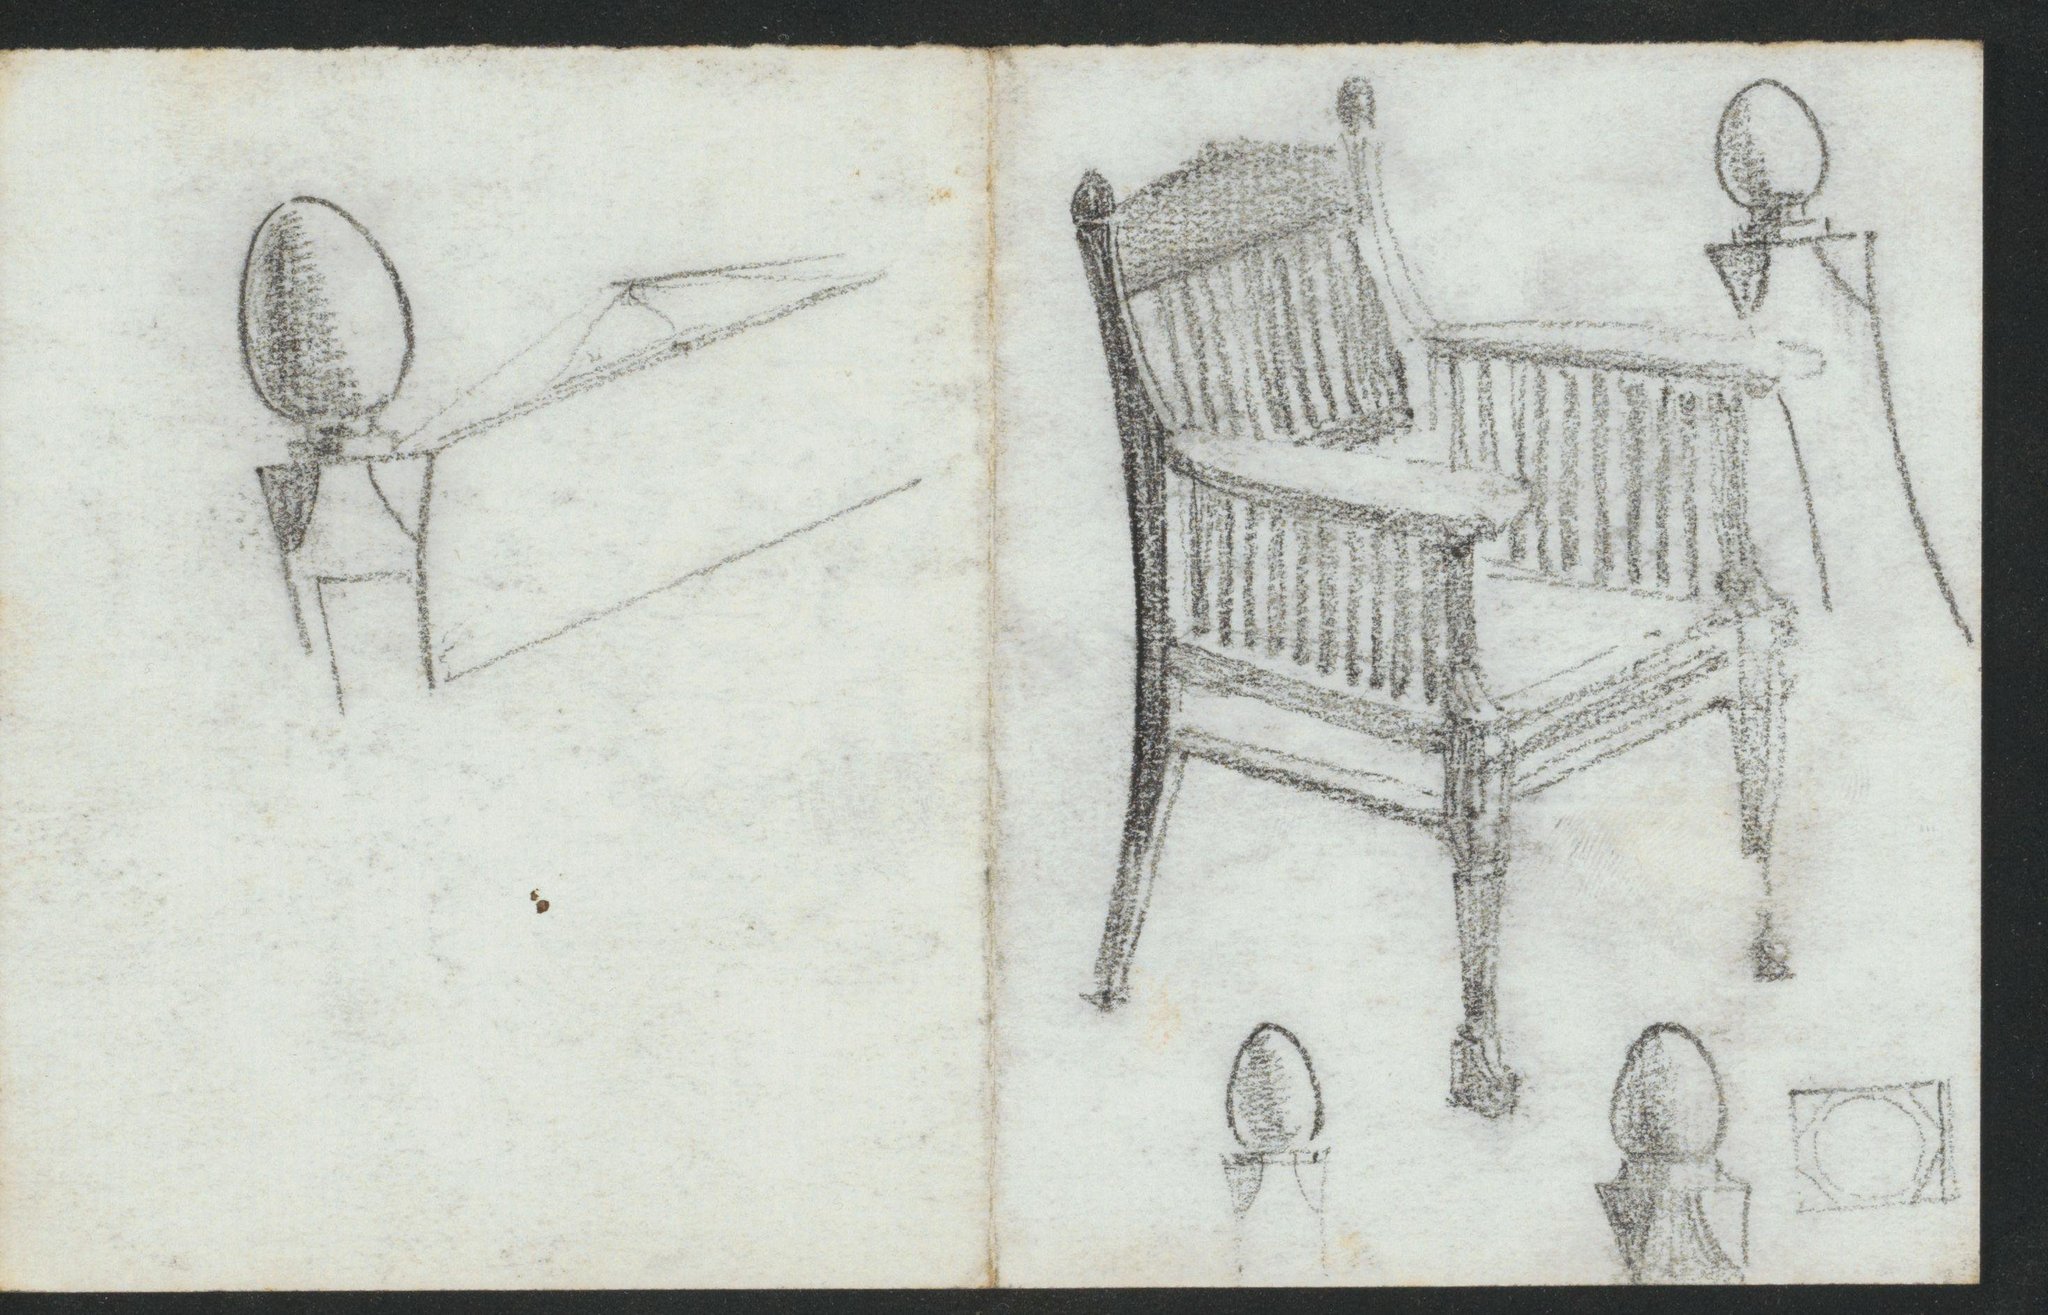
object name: drawing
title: Stoel en ornamenten op sokkels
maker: gerrit willem dijsselhof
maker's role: designer, draughtsman, print maker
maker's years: 1866-1924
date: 1876-1924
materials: chalk, paper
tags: ornaments ~ art, chair